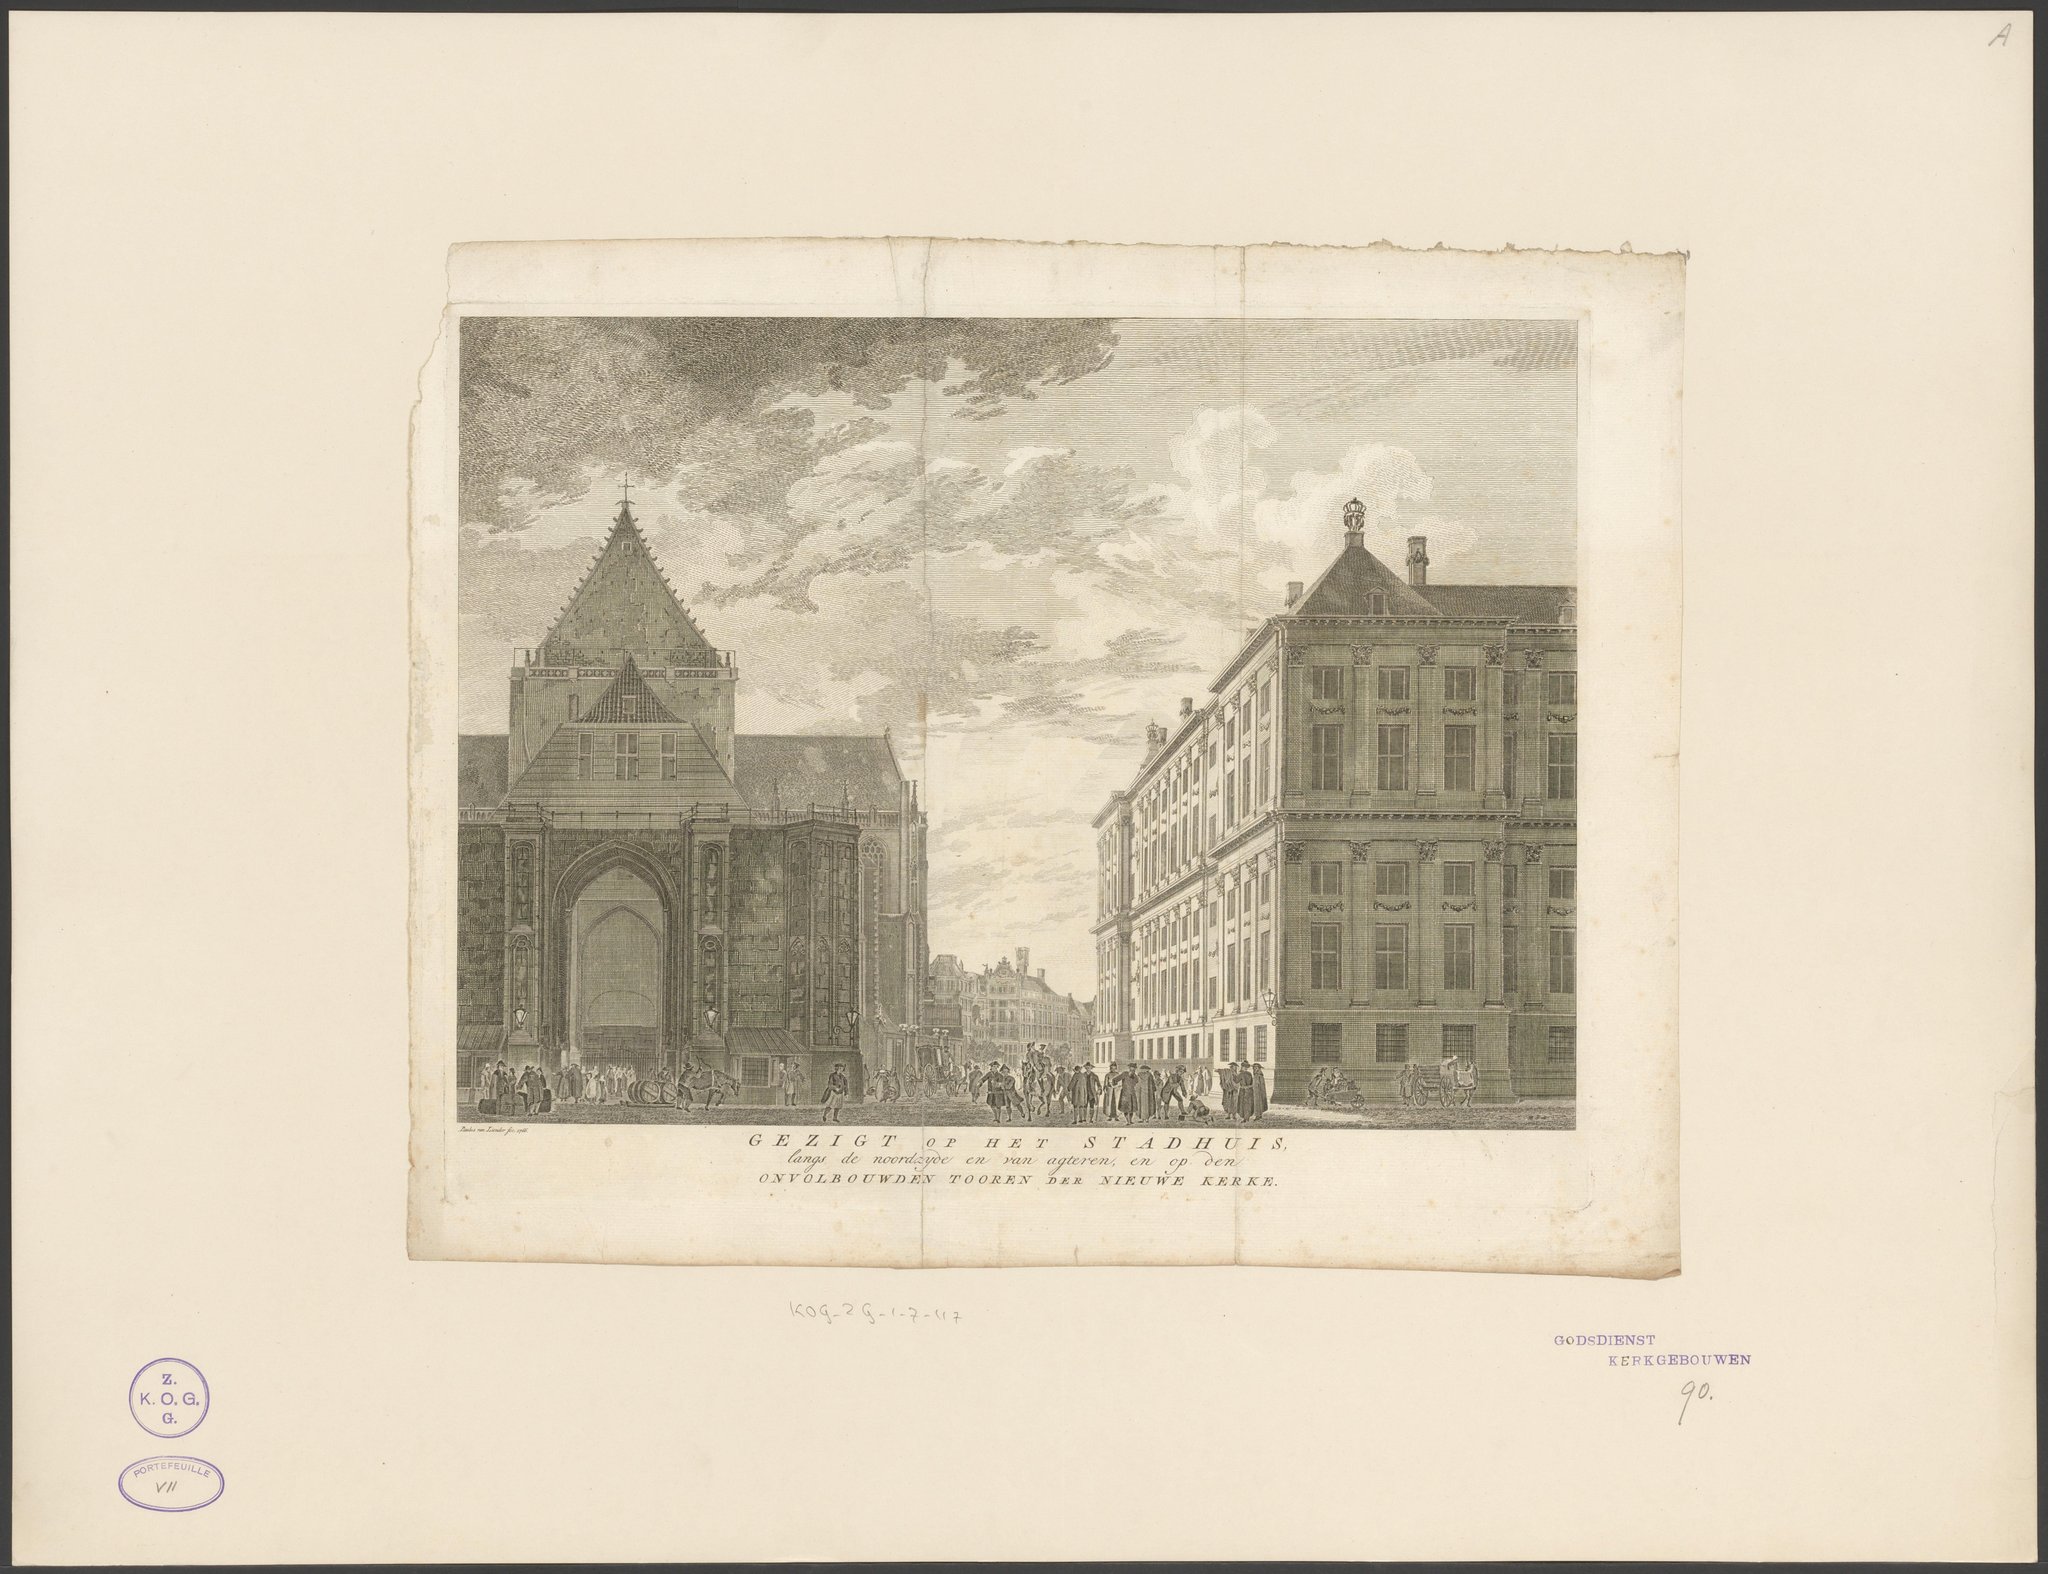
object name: print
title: Gezicht op Stadhuis van Amsterdam en Nieuwe Kerk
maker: paulus van liender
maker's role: draughtsman, print maker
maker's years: 1731-1797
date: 1766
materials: paper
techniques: engraving, etching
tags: church (exterior), townhall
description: Prent mogelijk uit: Wagenaar, Jan. Amsterdam, in zyne opkomst, aanwas, geschiedenissen, voorregten, koophandel, gebouwen, kerkenstaat, schoolen, schutterye, gilden en regeringe, beschreeven. 3 dln. Amsterdam: Isaak Tirion, 1765, dl. 2, tussen p. 110 en 111.